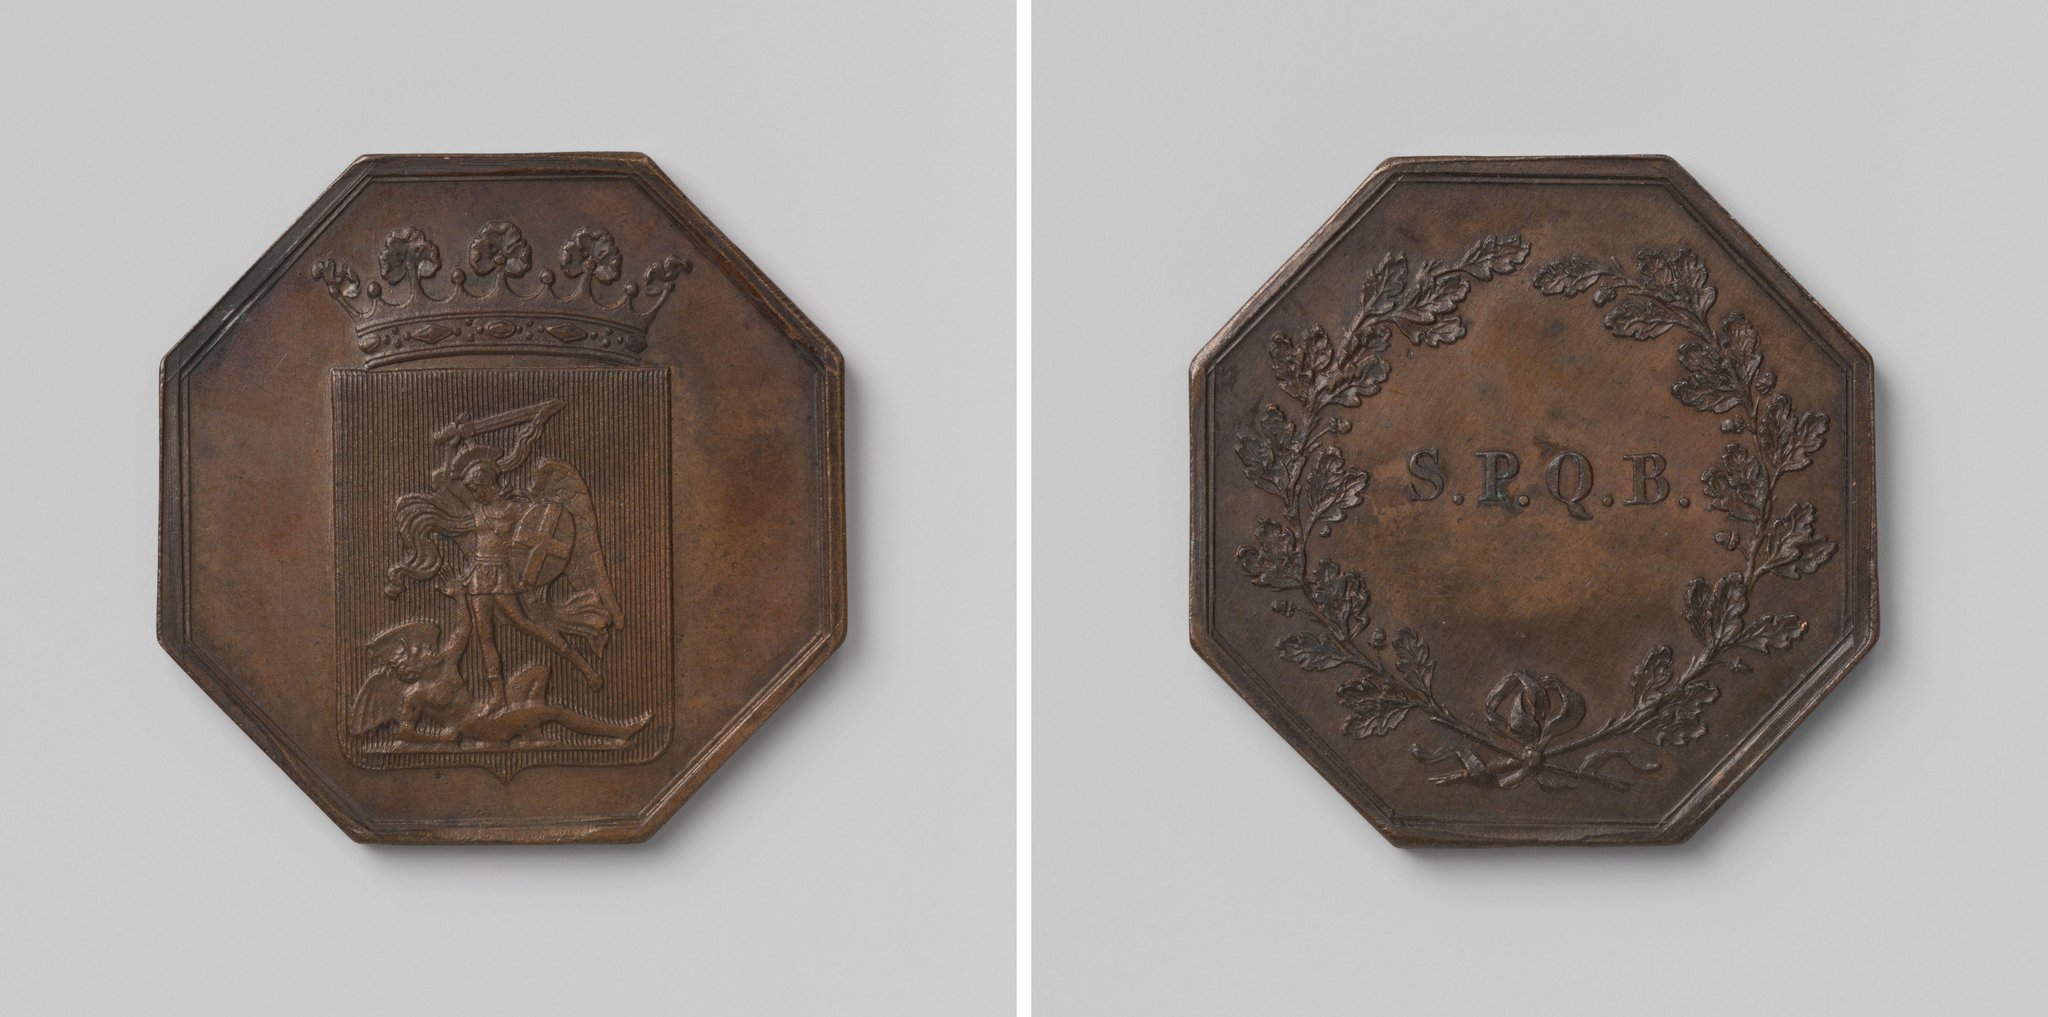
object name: raadspenning, raadsteken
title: Raadspenning van de stad Brussel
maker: Anonymous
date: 1818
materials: bronze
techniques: striking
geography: brussels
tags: brussels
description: achthoekige penning. Voorzijde: gekroond wapenschild. Keerzijde: monogram van letters S, P, Q en B binnen eikekrans